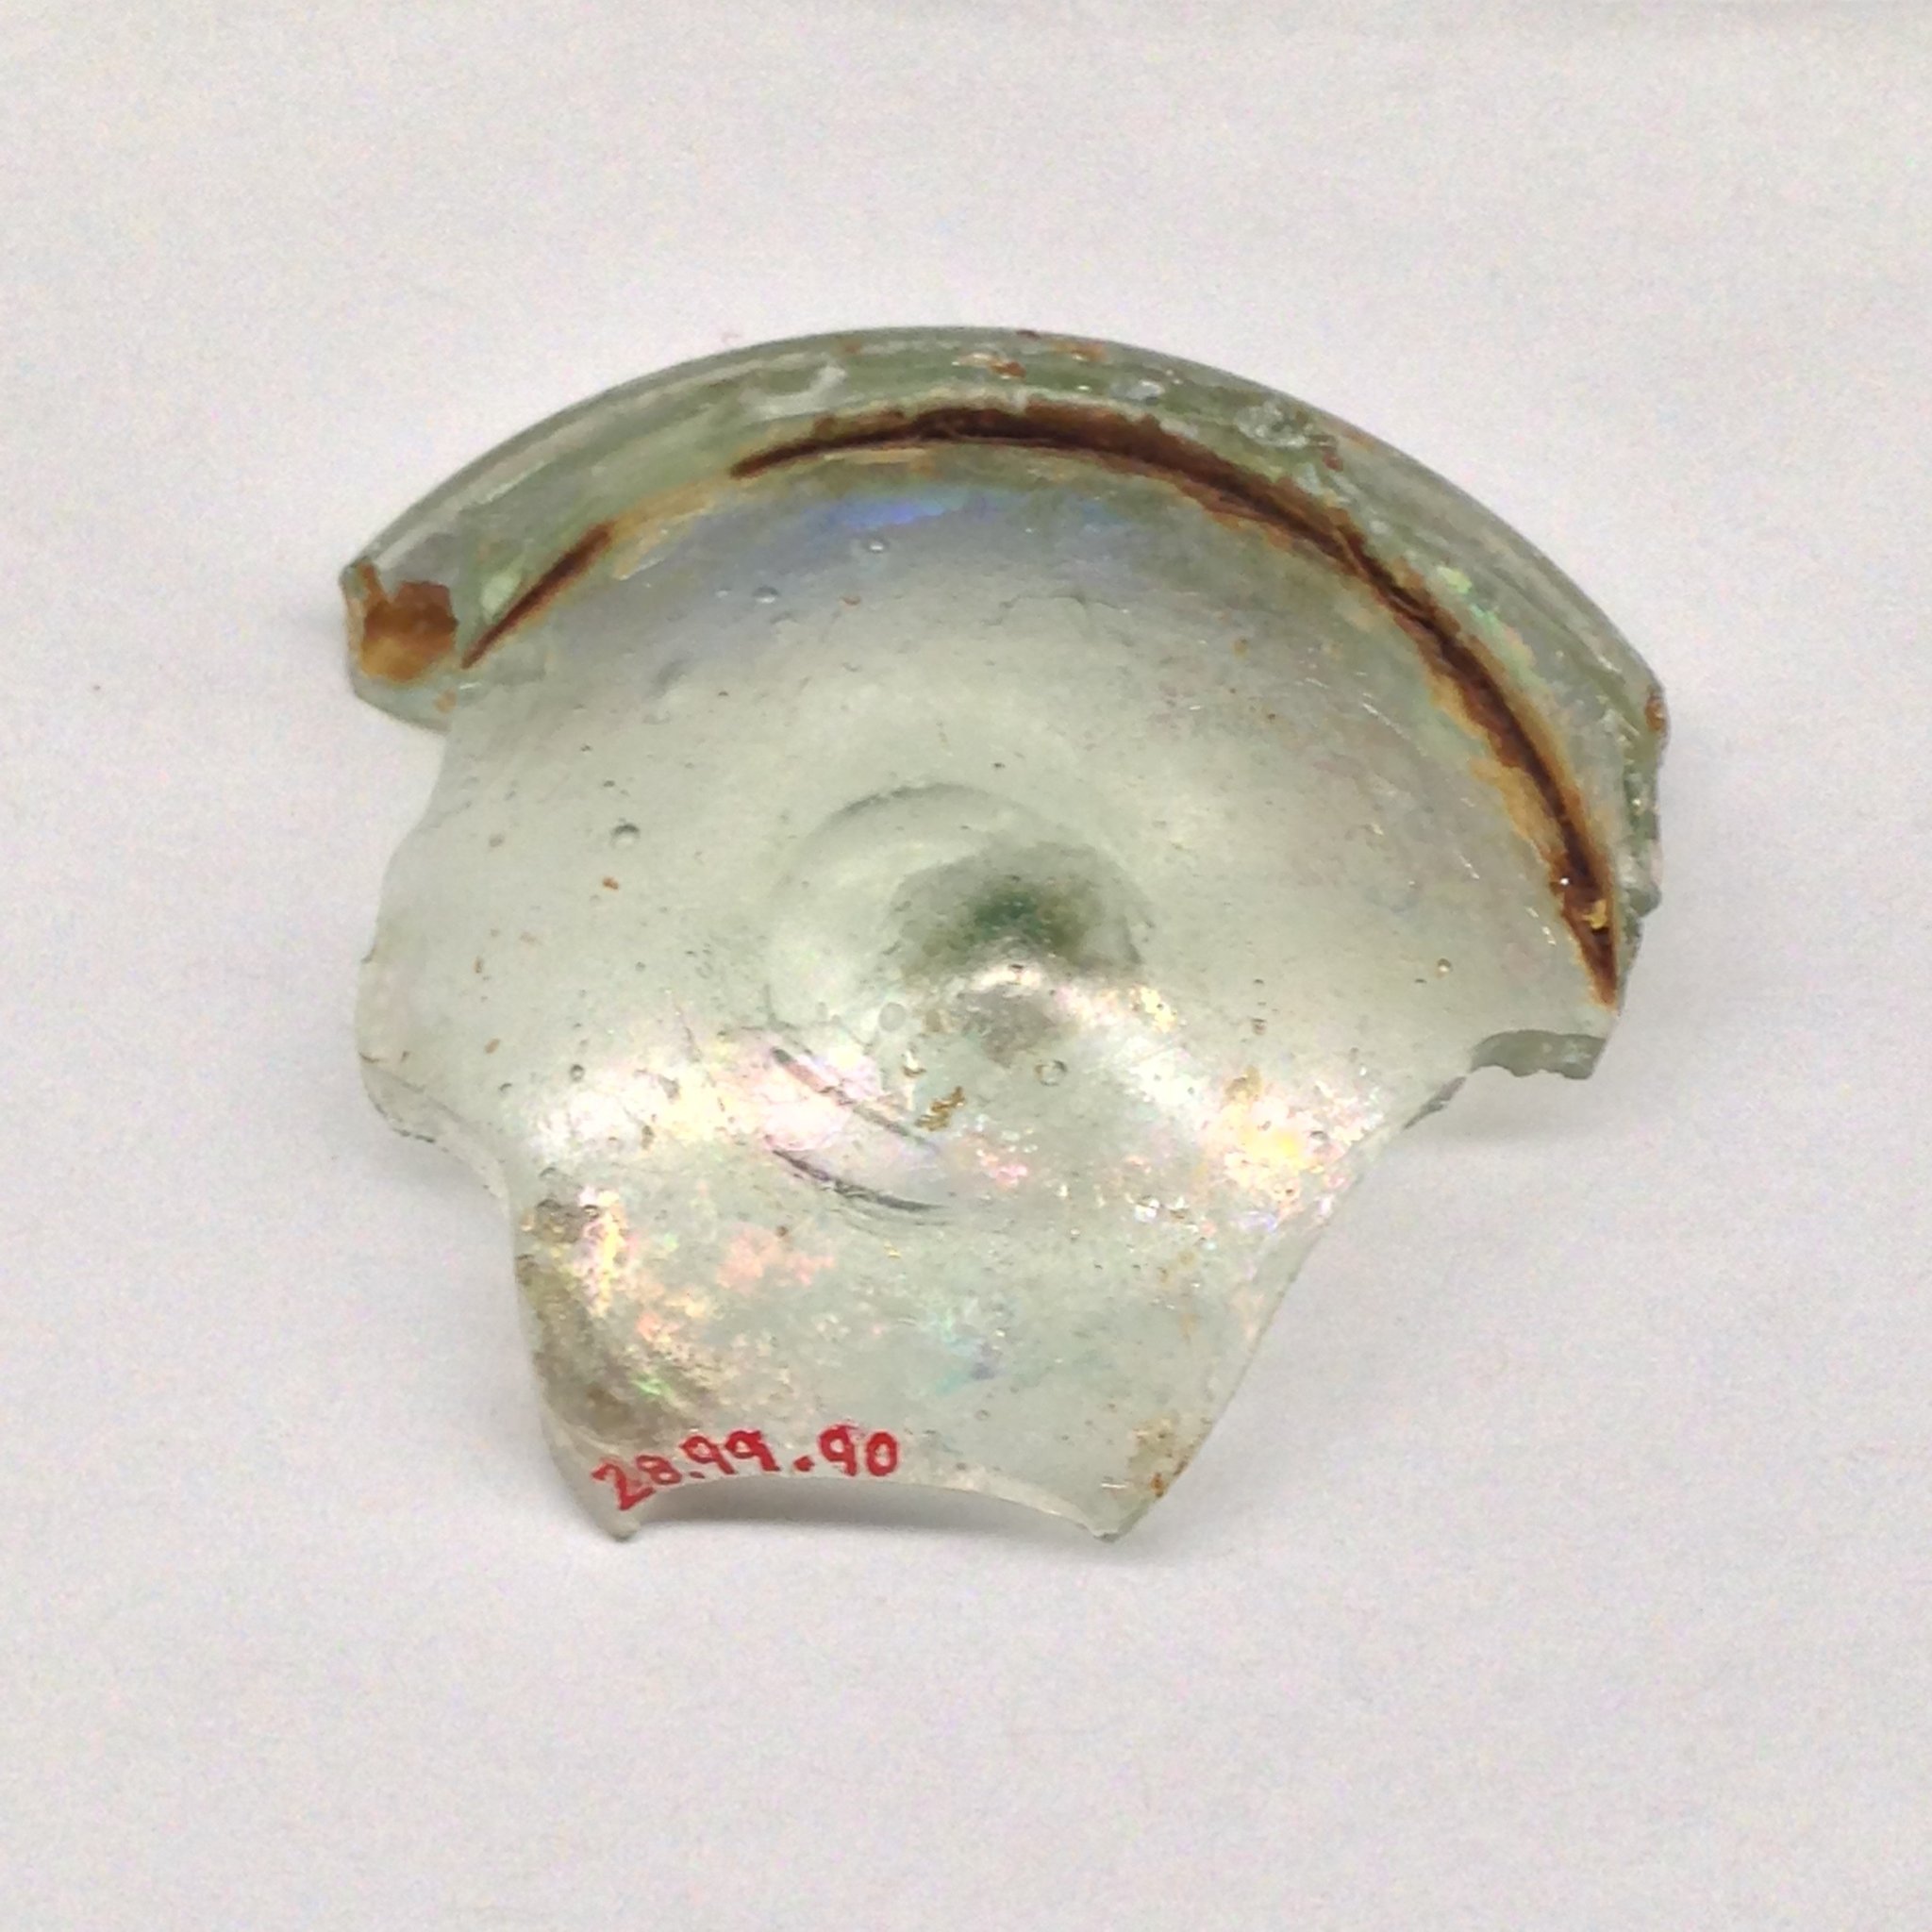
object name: fragment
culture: european or middle eastern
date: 1150-1250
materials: ceramic, glass